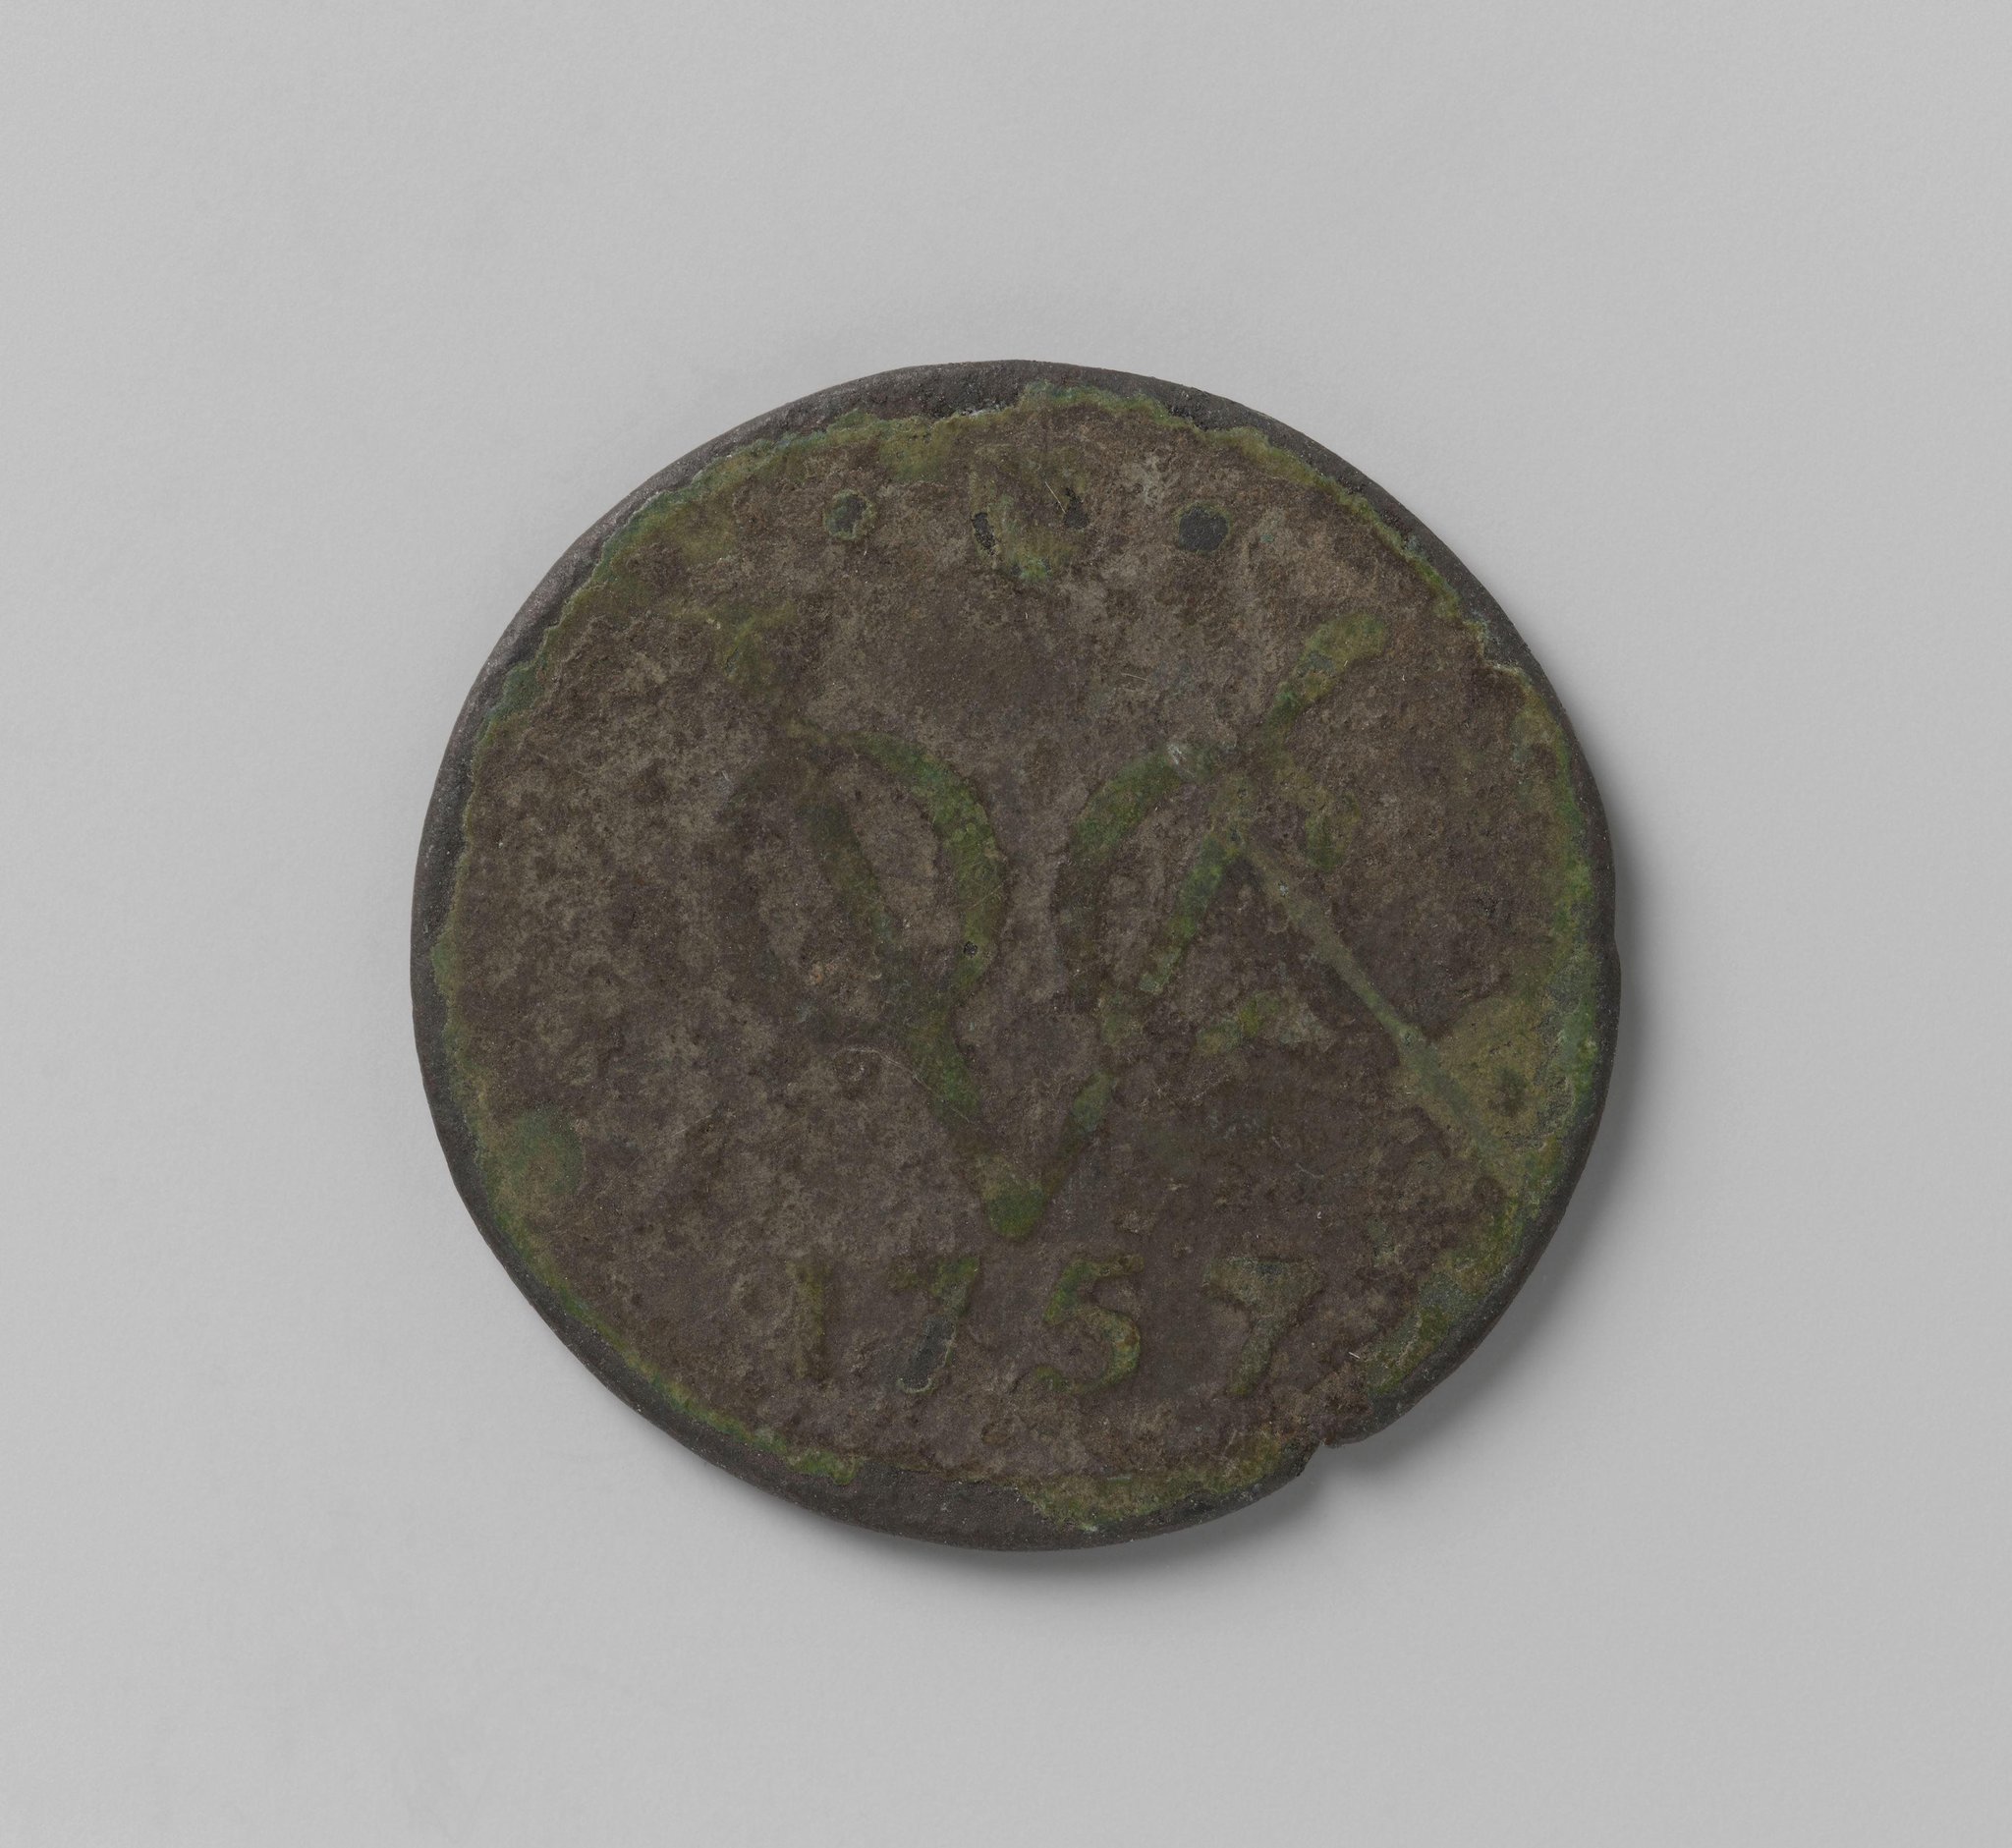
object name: coin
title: ½ duit van de VOC uit de stad Utrecht,1757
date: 1757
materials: copper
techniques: striking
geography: utrecht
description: Koperen munt. Voorzijde: gekroond ingebogen wapenschild van de stad Utrecht. Keerzijde: monogram van de VOC, waarboven muntteken en waaronder jaartal. Gladde rand.